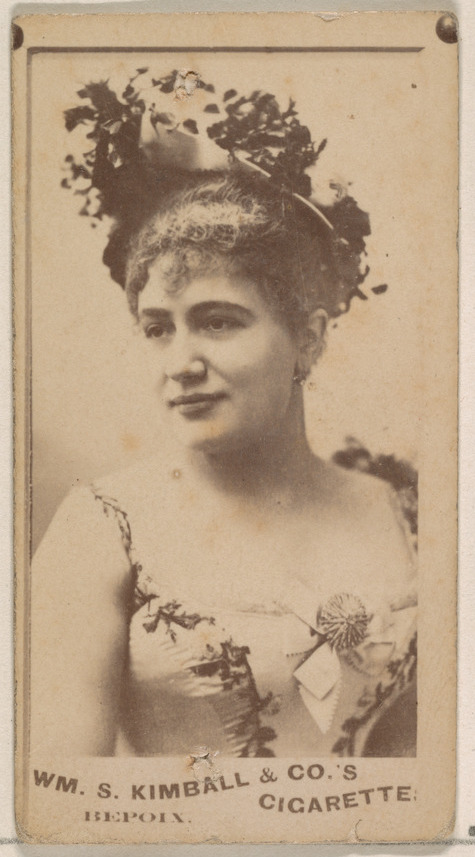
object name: photograph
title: Miss Bepoix, from the Actresses series (N203) issued by Wm. S. Kimball & Co.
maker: william s. kimball & company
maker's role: publisher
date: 1889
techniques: color lithograph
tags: portraits,women,actresses